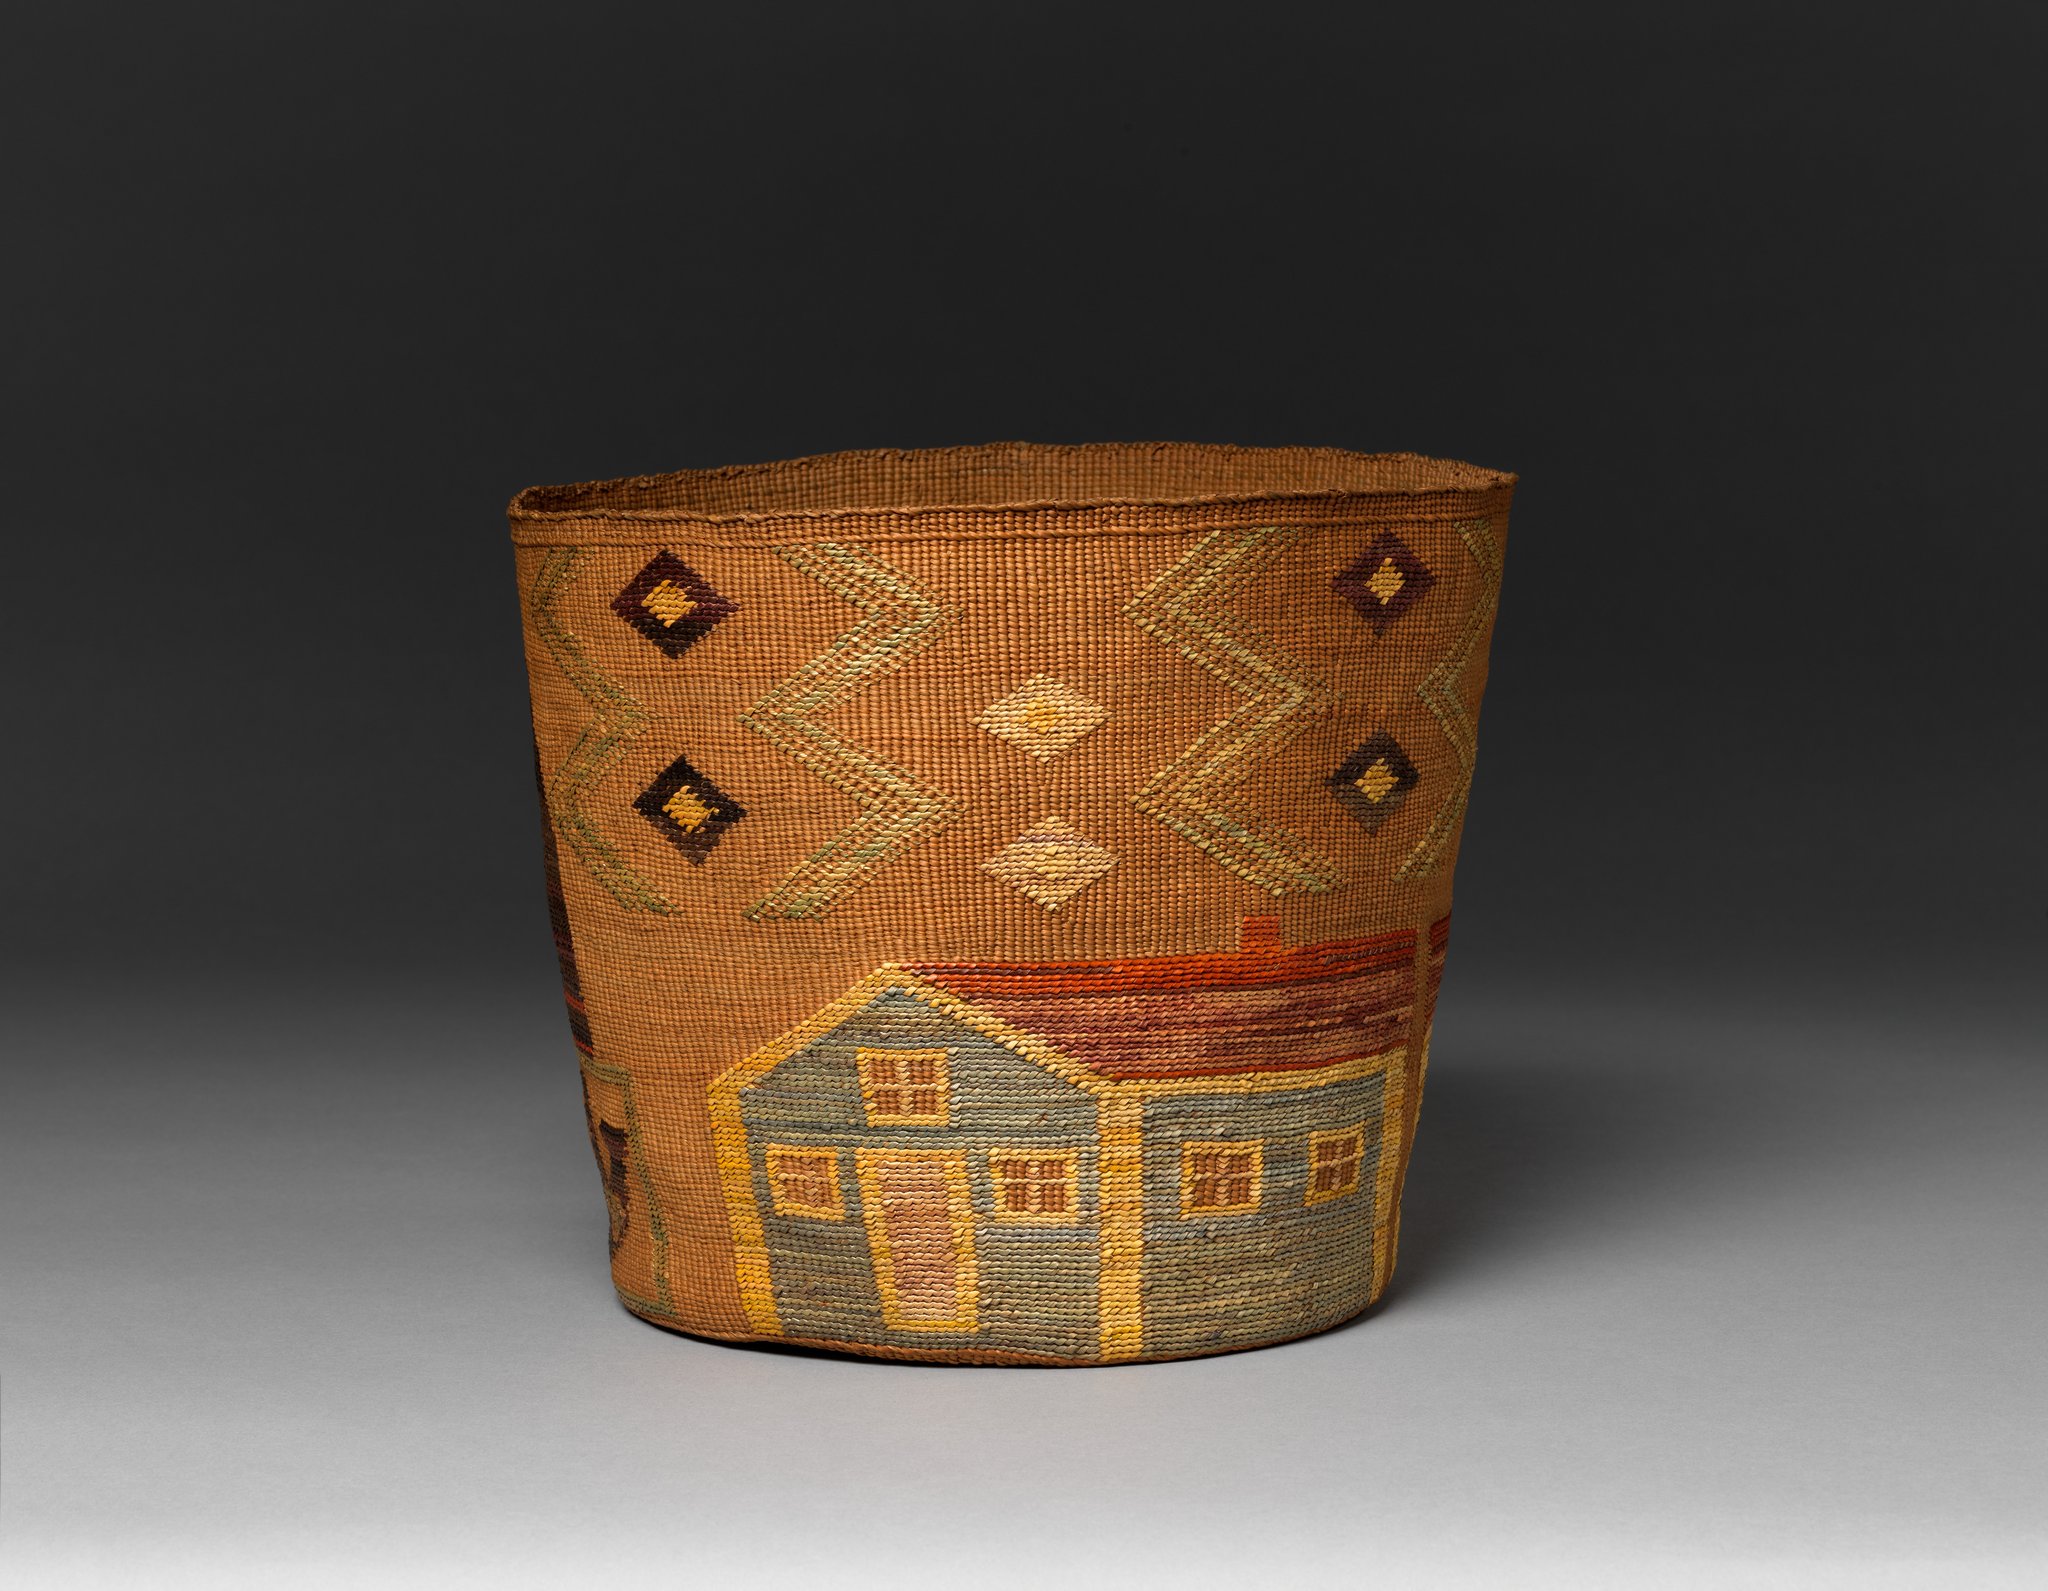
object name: basket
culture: tlingit or native american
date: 1900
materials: wood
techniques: dyeing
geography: united states